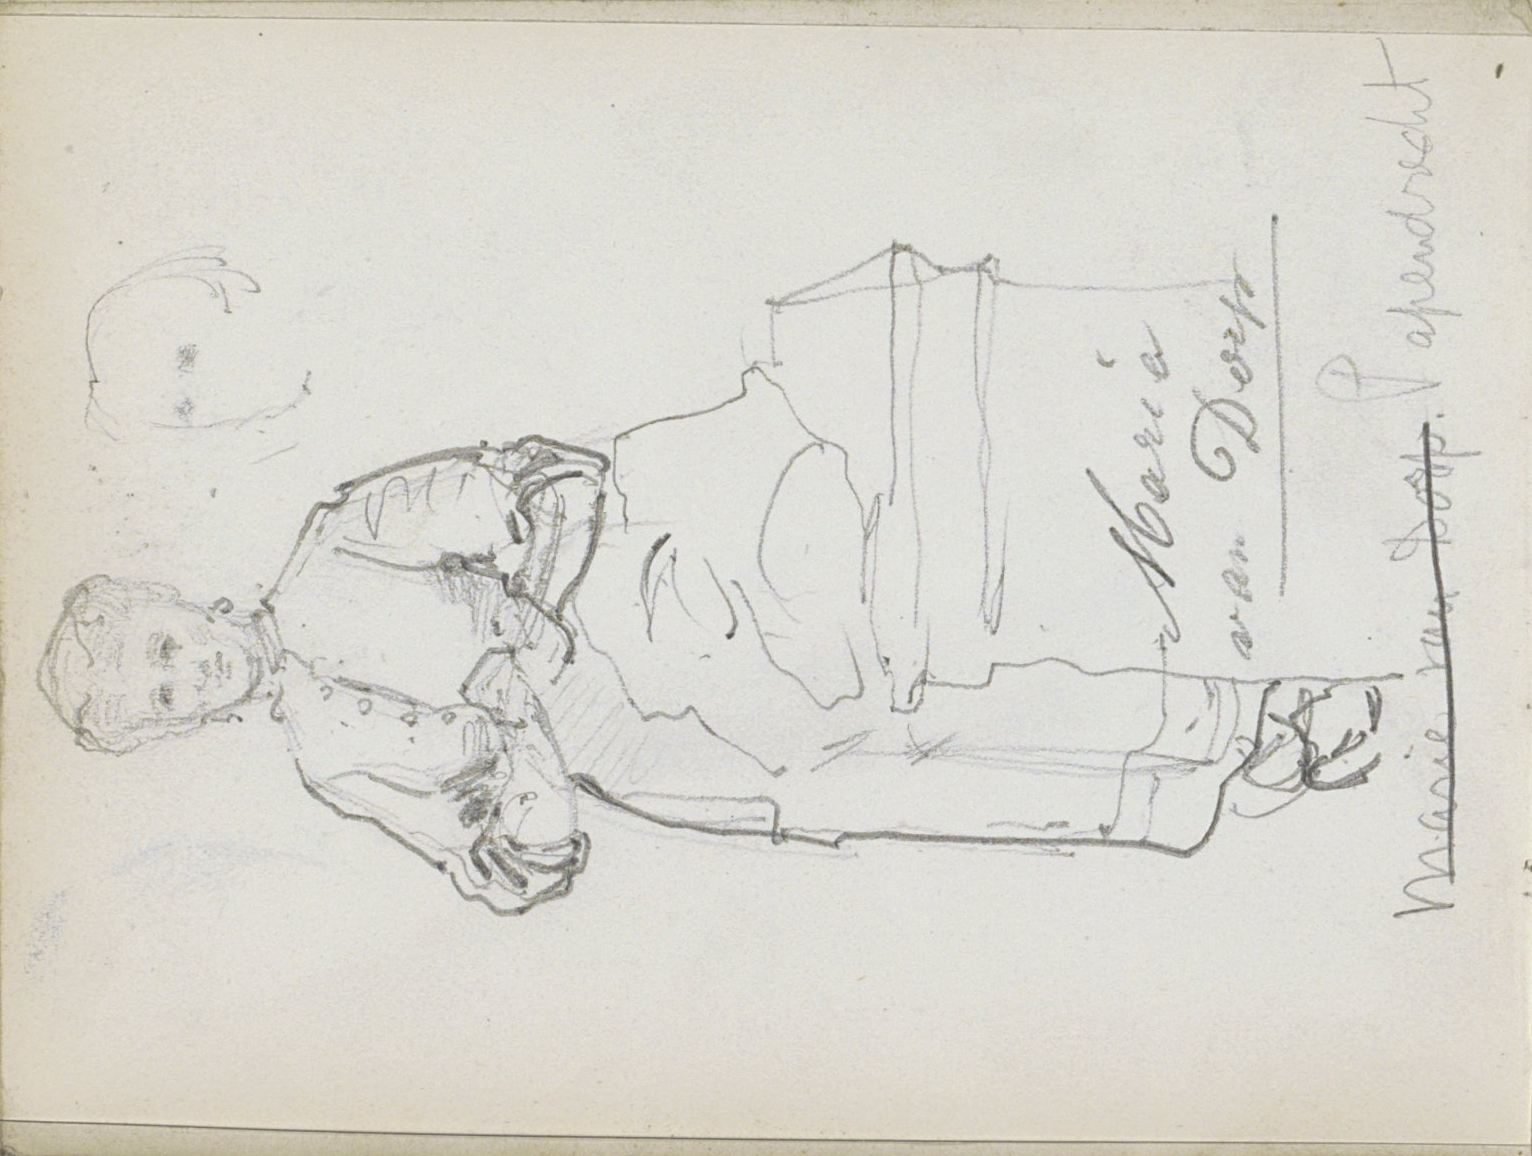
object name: sketchbook leaf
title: Portret van Maria van Dorp uit Papendrecht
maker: george clausen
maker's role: draughtsman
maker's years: 1852-1912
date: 1874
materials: paper, pencil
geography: papendrecht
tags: standing figure, adult woman, hands folded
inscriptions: annotation: ‘Maria/ van Dorp/ Papendrecht’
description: De vrouw staat en heeft de handen in elkaar gevouwen. Blad 27 verso uit een schetsboek met 37 bladen.